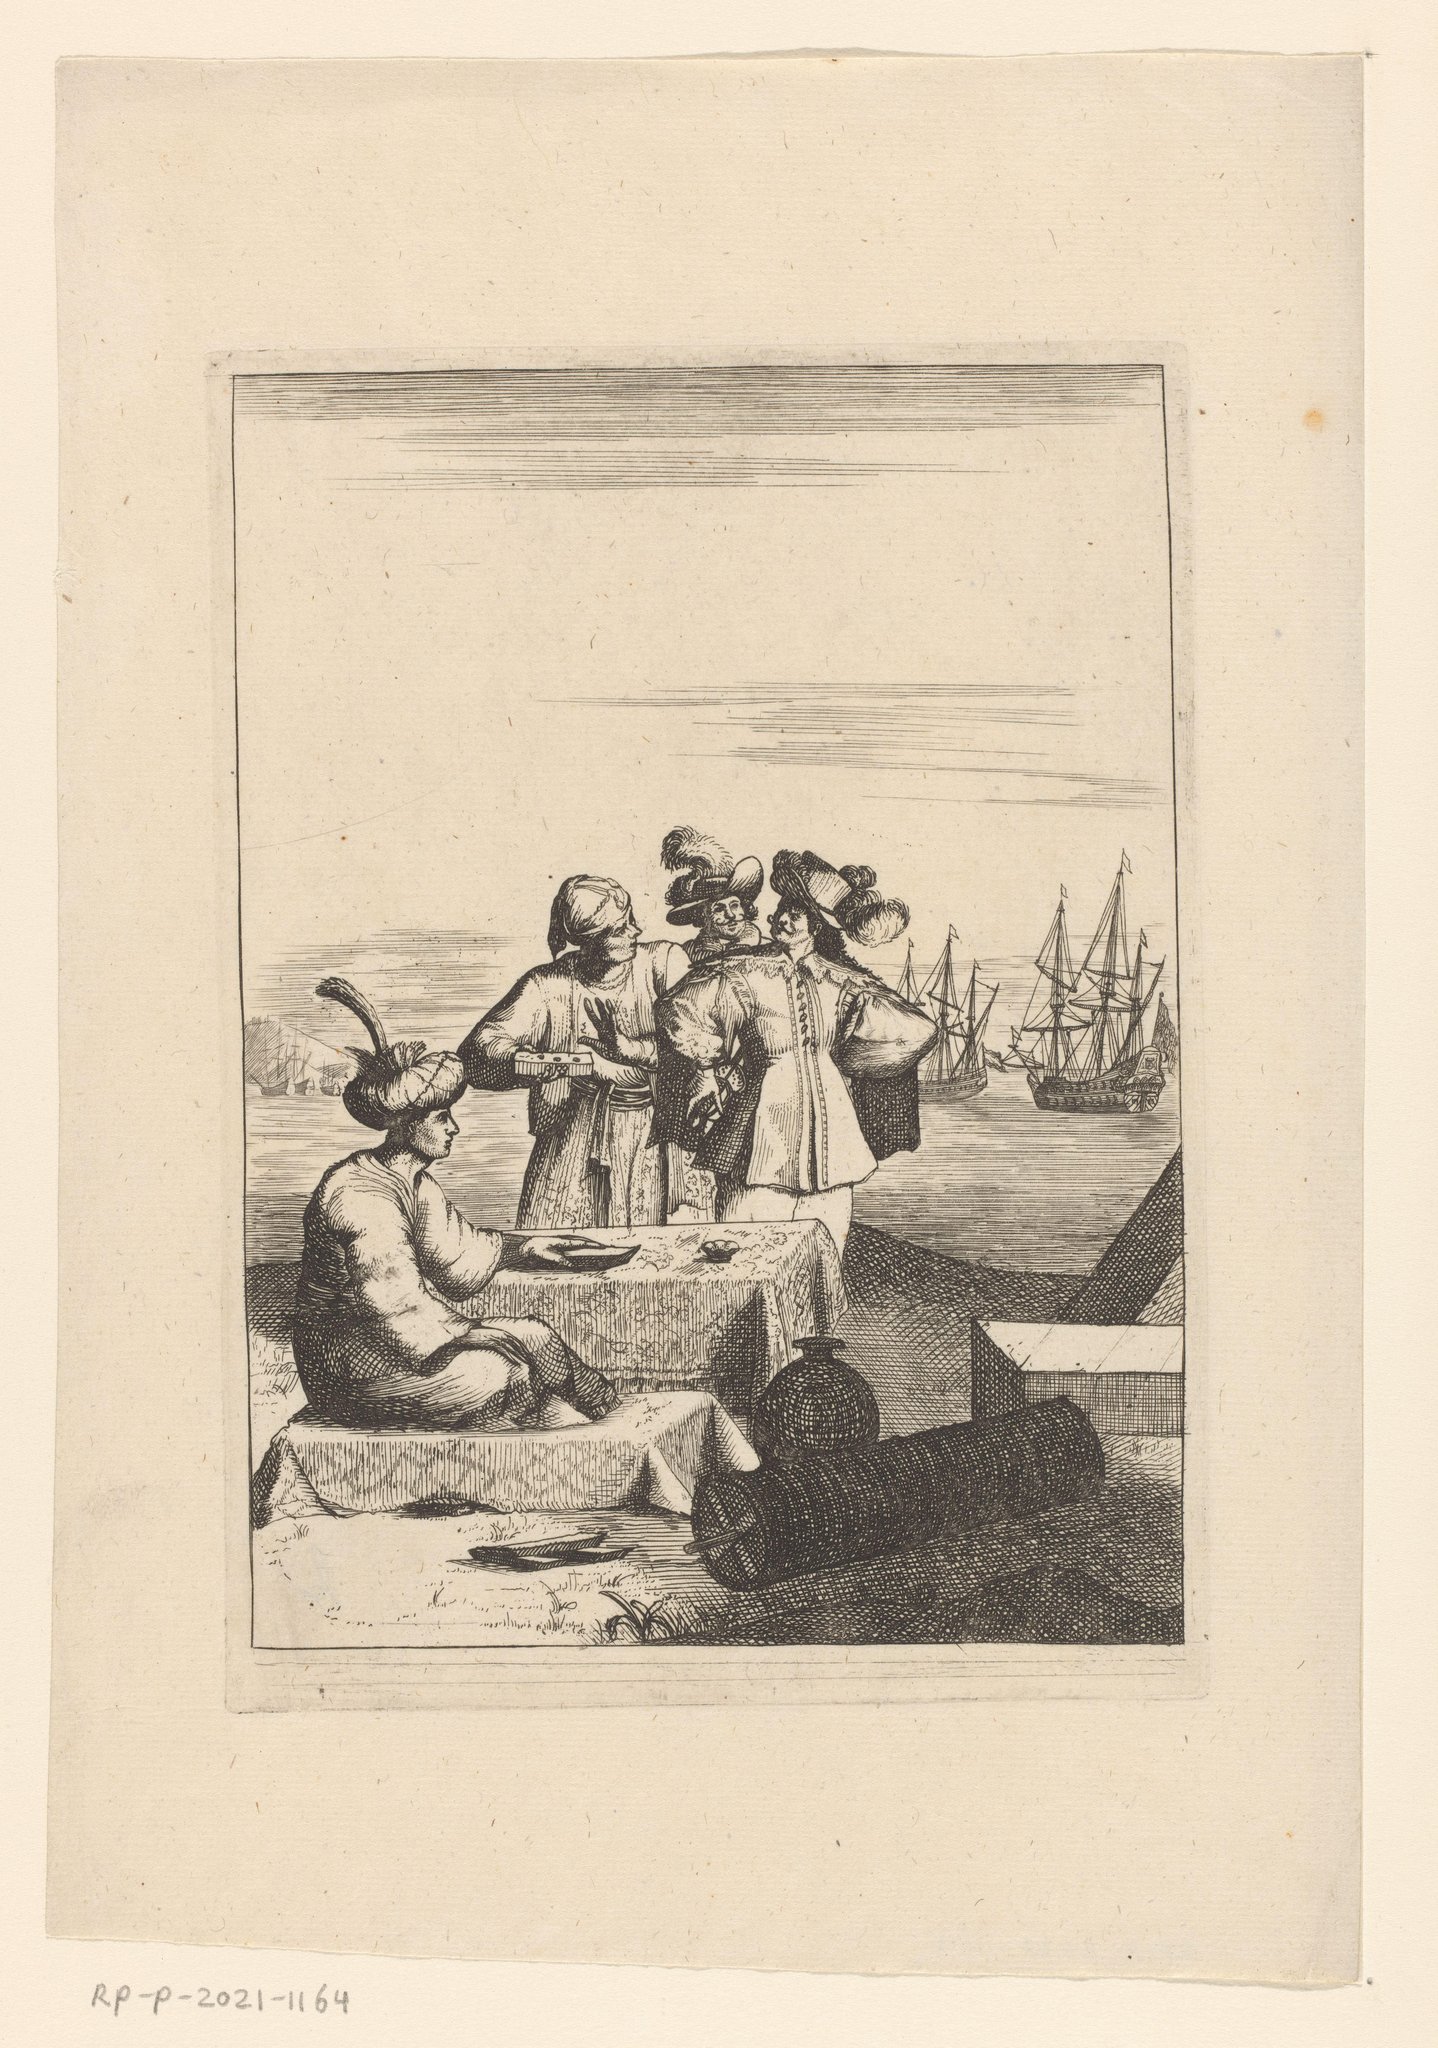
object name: print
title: Voorstellingen naar de kaart 'Oost Indien' van Romeyn de Hooghe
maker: Anonymous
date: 1668-1725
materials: paper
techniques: etching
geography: netherlands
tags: sailing-ship, sailing-boat, head-gear: turban, merchant shipping, shipping trade, merchant, salesman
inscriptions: collector's mark: Lugt 2228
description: De prent is mogelijk een proefdruk en bedoeld als illustratie voor een (gefantaseerd) reisverslag, of uitgegeven als serie. De prenten zijn gemaakt naar voorstellingen van Romeyn de Hooghe op de kaart 'Oost Indien', ca. 1668 uitgegeven door Hugo Allard. Sommige prenten uit de serie zijn gebruikt als voorbeeld voor een porseleinset van Meissen, 1720-1725. Deze prent is aanwezig in het Meissen-archief, maar zover bekend niet gebruikt als porseleinontwerp.